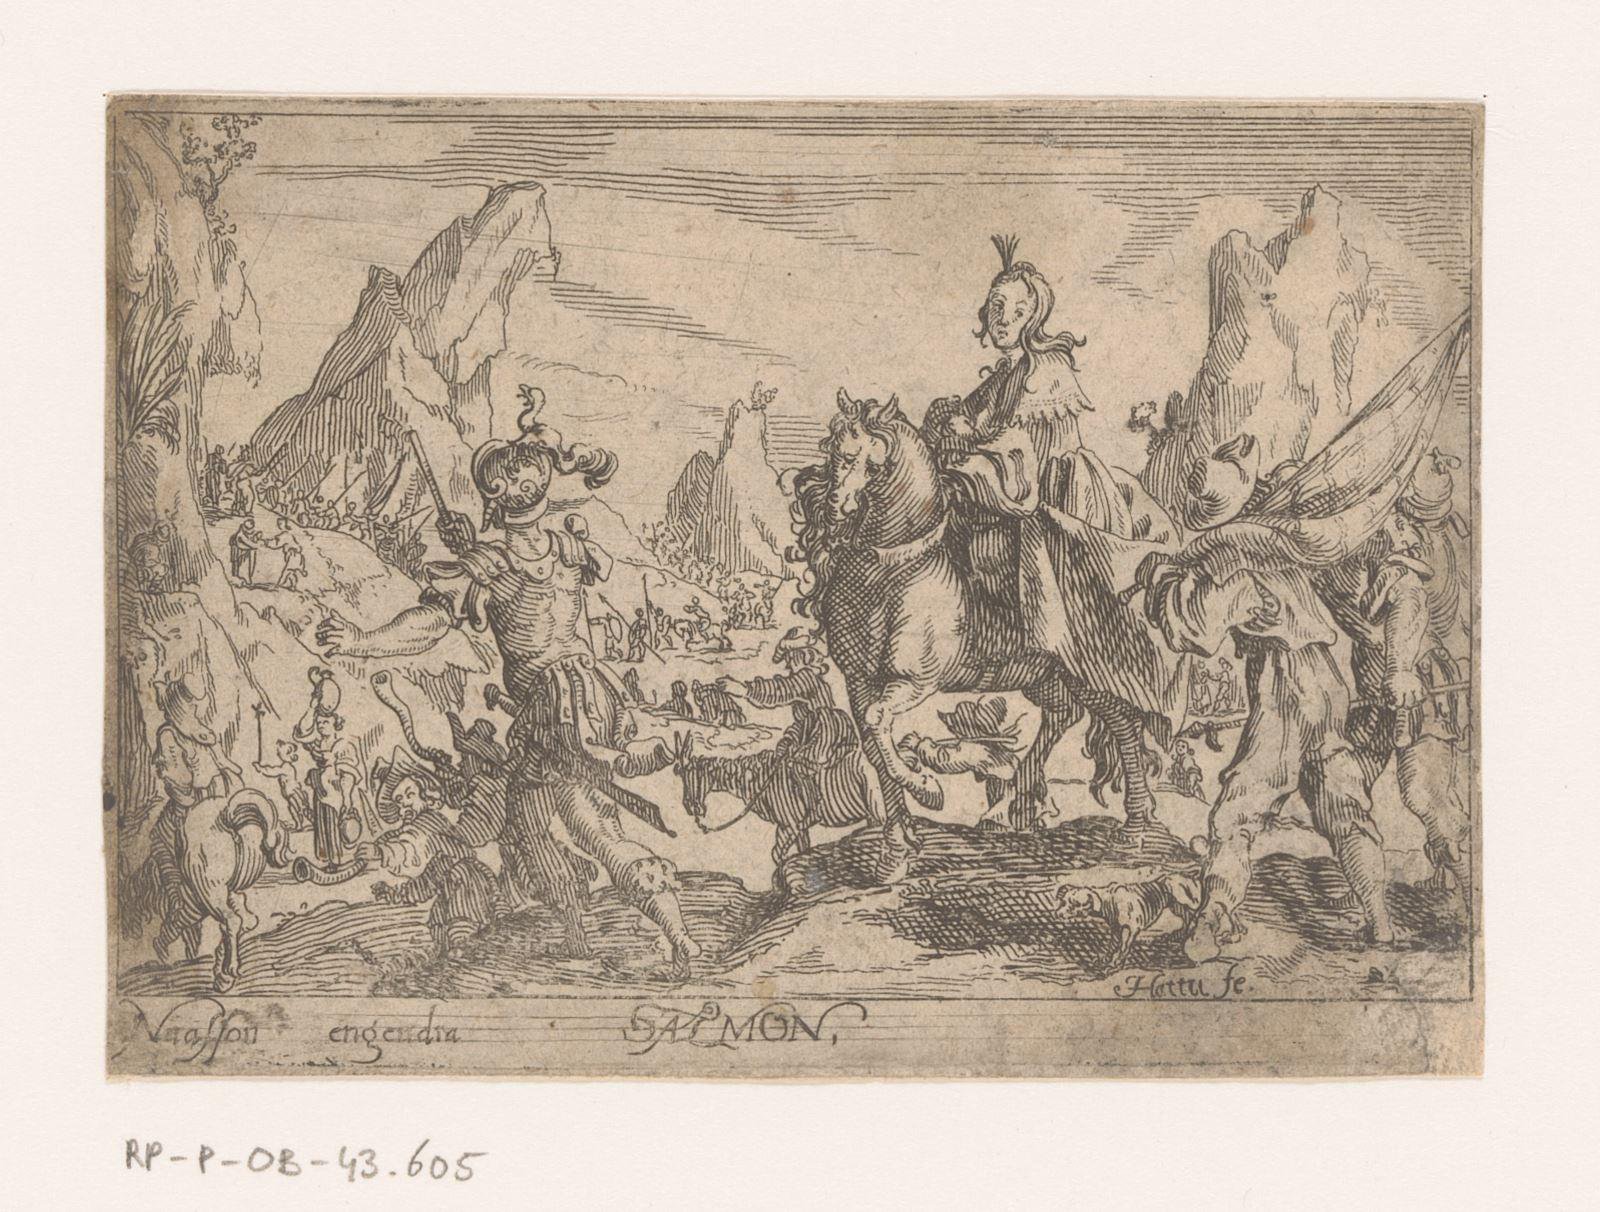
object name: print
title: Geboorte van Salmon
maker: j. hattu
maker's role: print maker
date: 1600-1699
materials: paper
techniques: etching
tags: horse, 'en route', traveller under way, mountains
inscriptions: collector's mark: Lugt 2228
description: Vrouw te paard, vermoedelijk de moeder van Salmon, de zoon van Nahesson. Man met vaandel en vele anderen in berglandschap. Mogelijk een voorstelling van de veertigjarige tocht door de wildernis.